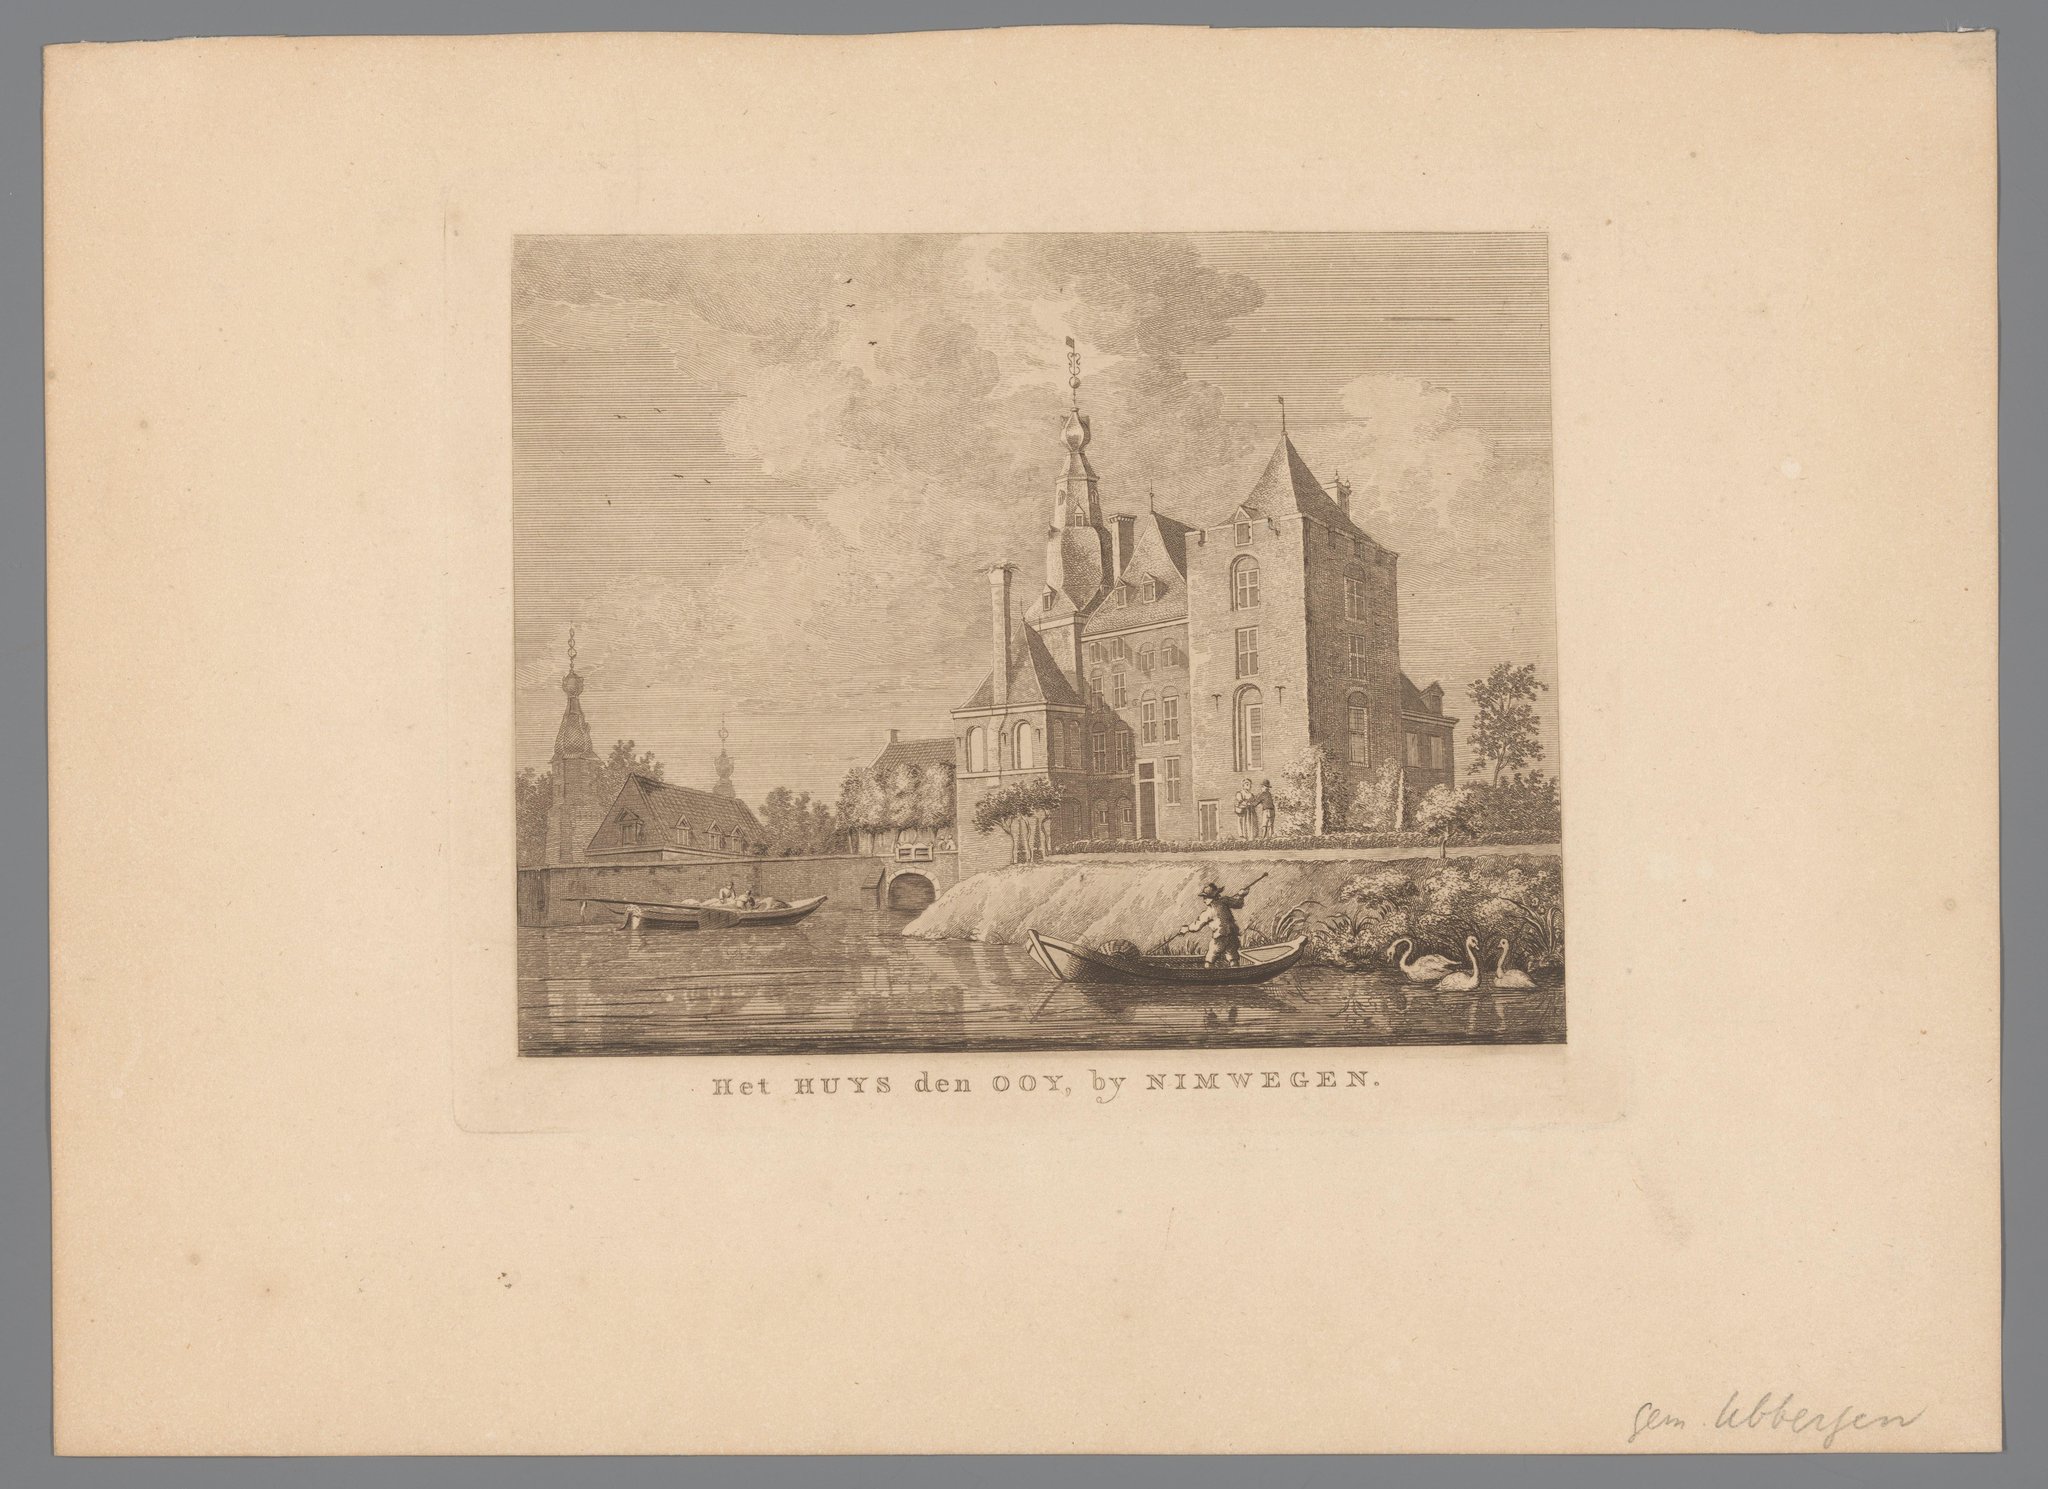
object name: print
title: Het Huys den Ooy, by Nimwegen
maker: Anonymous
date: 1770-1830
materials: paper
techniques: etching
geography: netherlands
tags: castle, landscape with tower or castle (+ city(-scape) with figures, staffage)